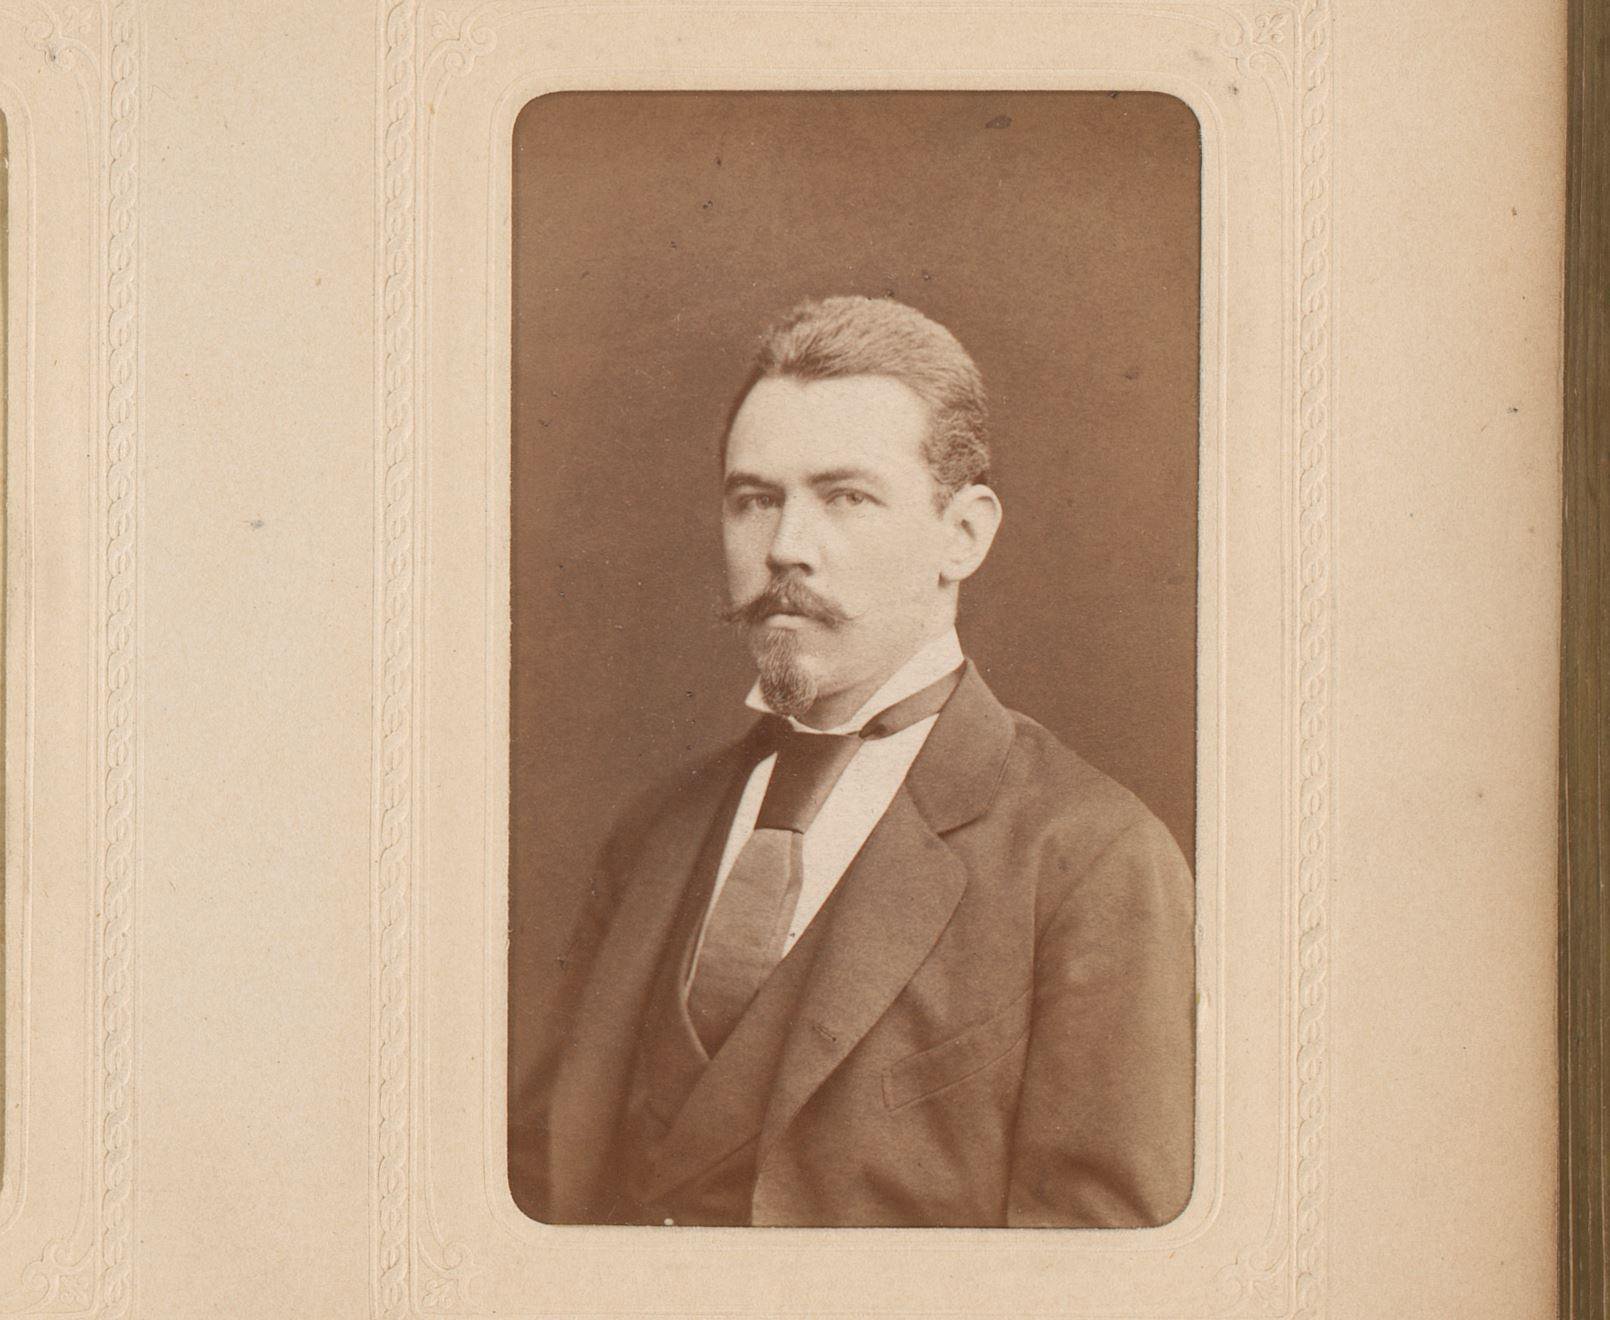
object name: photograph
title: Portret van een man met snor, sik en stropdas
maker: hynek fiedler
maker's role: painter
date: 1860-1900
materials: cardboard, photographic support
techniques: albumen print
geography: prague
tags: moustache, historical persons, beard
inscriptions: annotation: ‘AK’, name: ‘[.]aro[.]en odko[...]’, inscription: ‘H. Fiedler/ Fotograf i malir/ v PRAZE/ 783-II. Václavaské nam cis. 24 nove./ Matrice se zachová.’